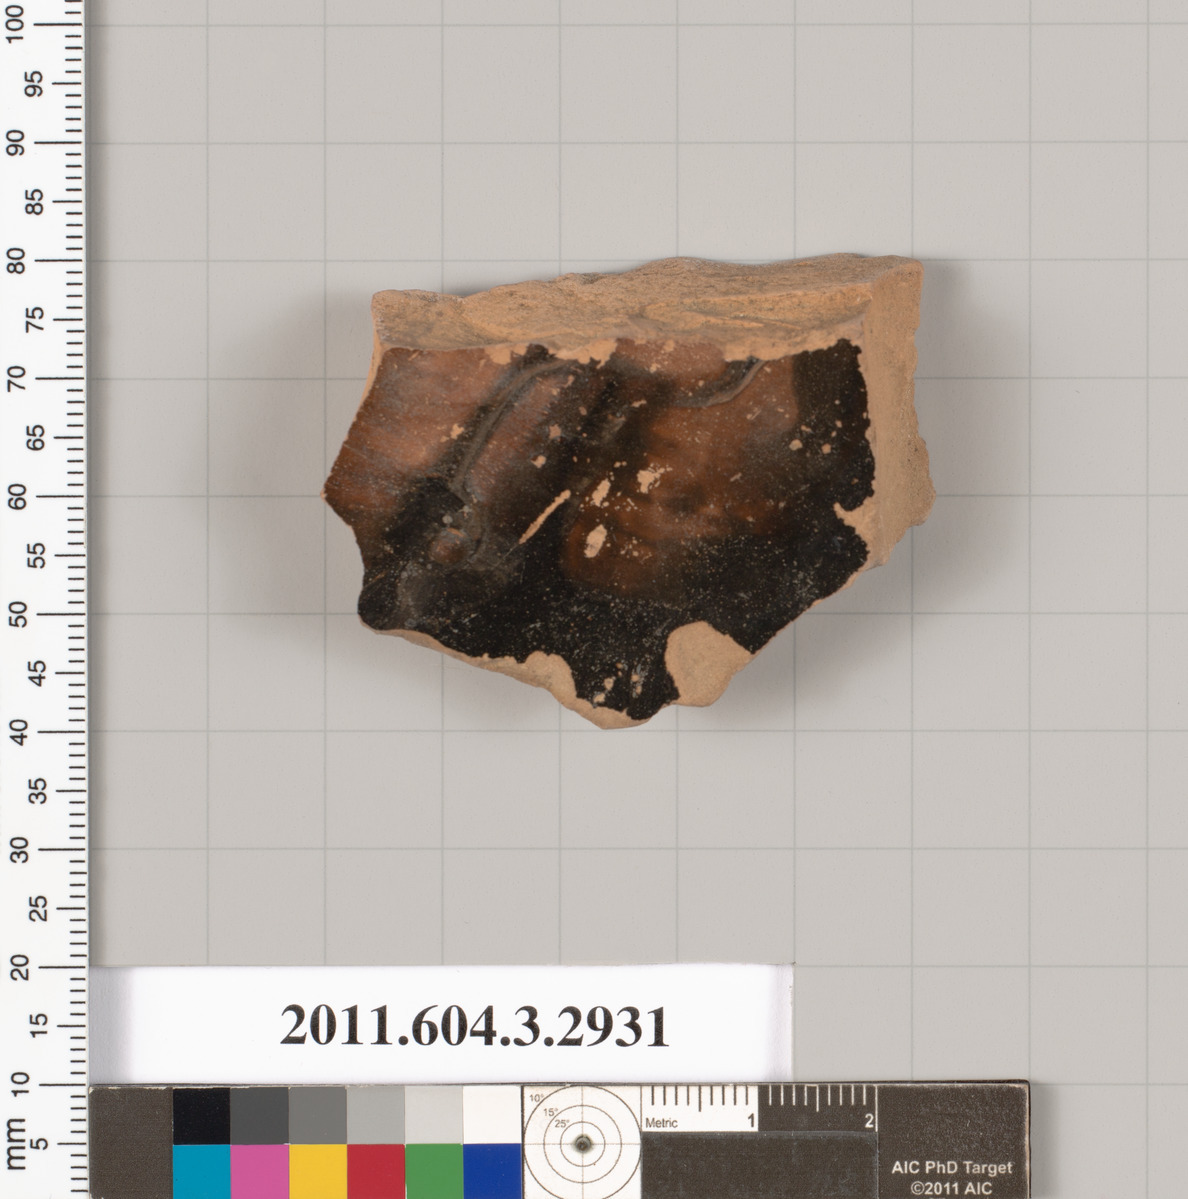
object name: undetermined open shape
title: Terracotta fragment of an open shape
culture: greek, attic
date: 600-401 BCE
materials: terracotta